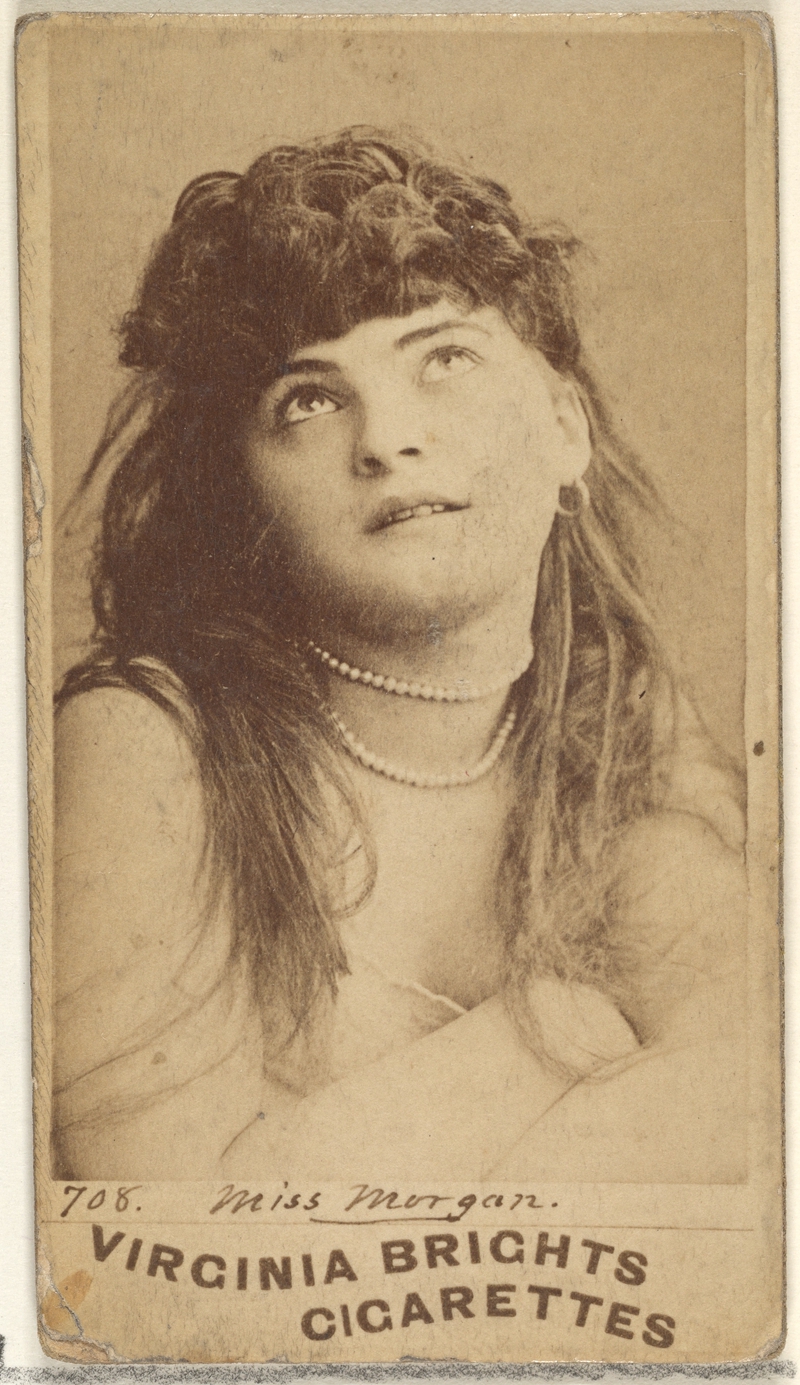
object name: photograph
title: Card 708, Miss Morgan, from the Actors and Actresses series (N45, Type 1) for Virginia Brights Cigarettes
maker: allen & ginter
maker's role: publisher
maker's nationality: american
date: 1888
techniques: albumen silver print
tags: portraits,women,actresses